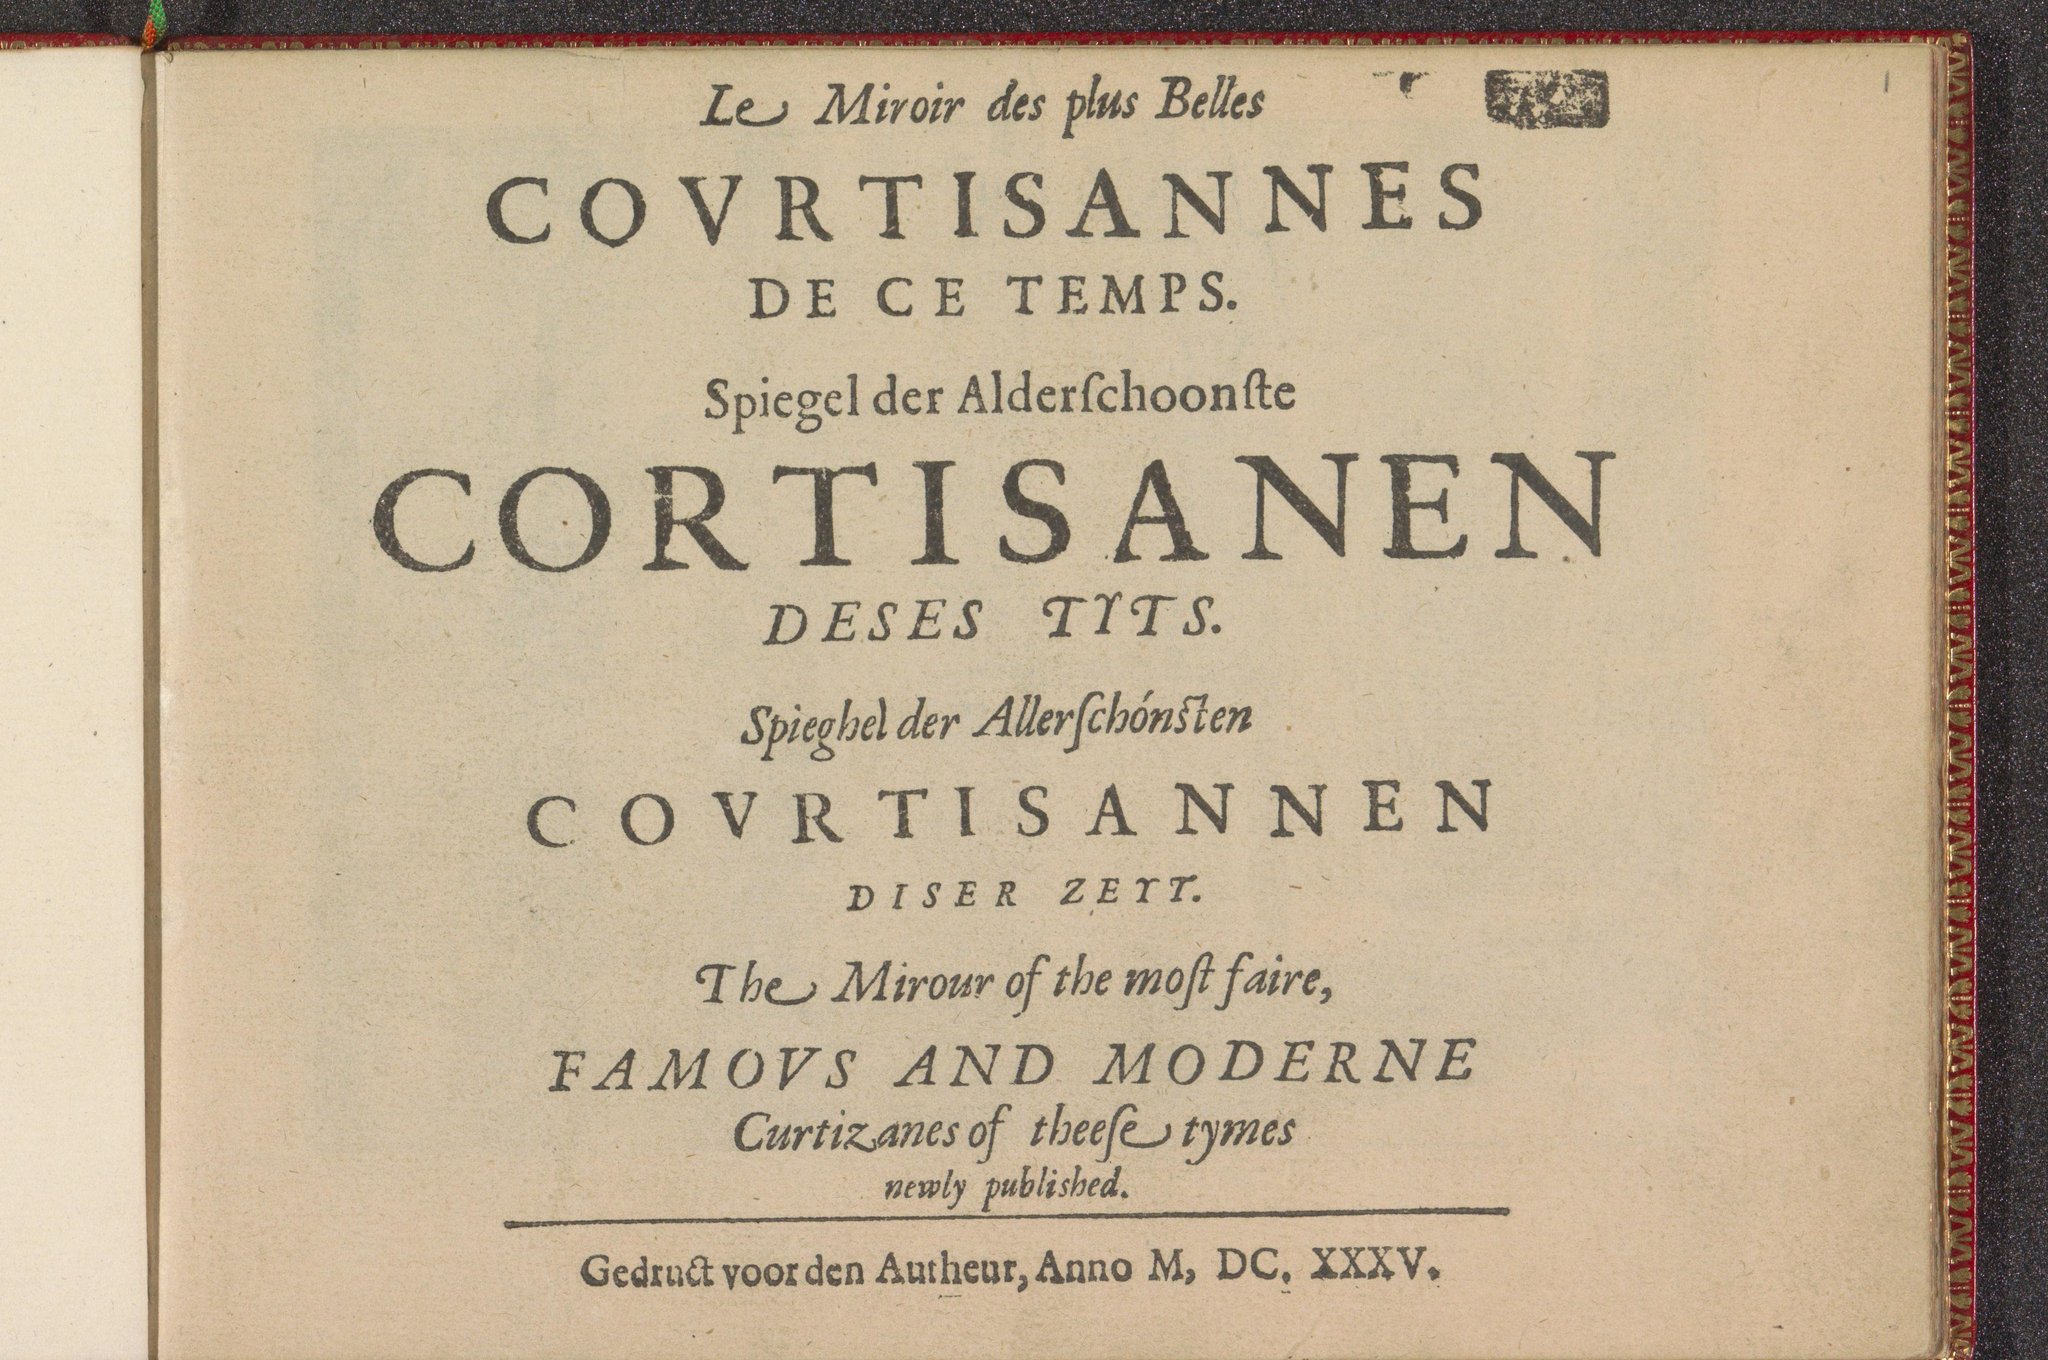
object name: titelblad, titelpagina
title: Titelpagina voor: Le Miroir des plus belles courtisannes de ce temps / Spiegel der alderschoonste cortisanen deses tyts / Spieghel der allerschónsten Courtisannen diser Zeit / The mirour of the most faire, famous and moderne curtizanes of theese tymes, 1630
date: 1635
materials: paper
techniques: letterpress printing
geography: utrecht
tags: title-page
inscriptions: collector's mark: ‘RIJKS / MUSM’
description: Deze titelpagina maakt deel uit van een album.